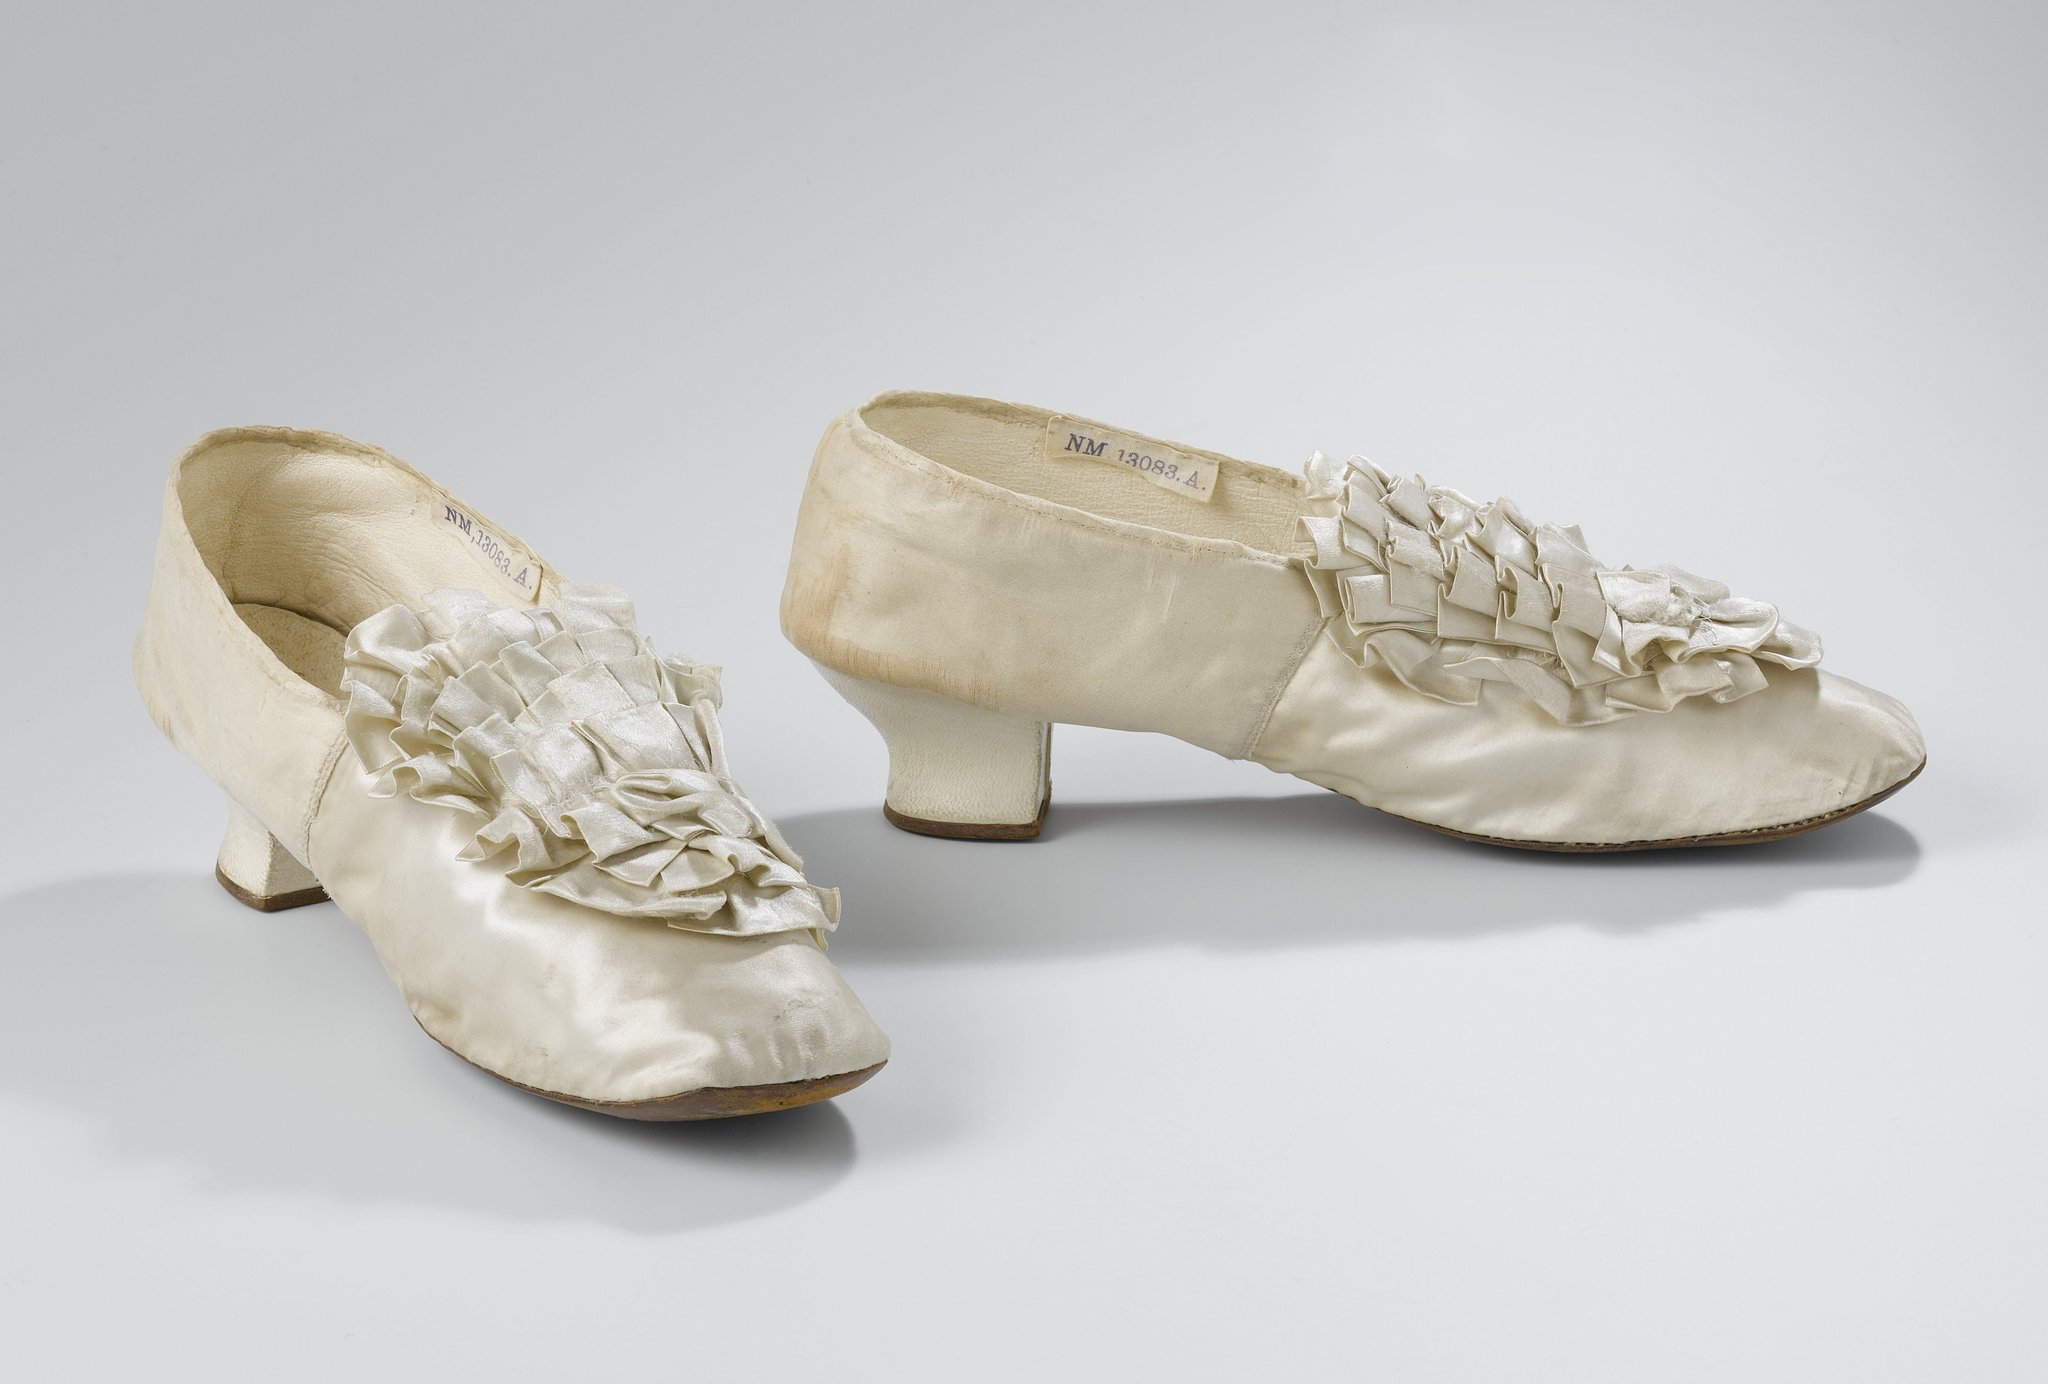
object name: womenswear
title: Damesschoen van ivoorwit satijn met rozet op de voorschoen en vierkante neus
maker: Anonymous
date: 1850-1860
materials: cotton, leather, rubber, silk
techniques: tanning, weave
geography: netherlands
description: Damesschoen van ivoorwit satijn. Model: Vierkante neus, één voorblad en één achterblad. De voorkant van de hak loopt recht naar beneden. De zijkant en achterkant van de hak zijn getailleerd en bekleed met ivoorwit satijn met donkerbruine rand leer van het achterlapje. Leren achterlapje met drie spijkers aan de hak vastgeslagen en leren zool. Achterblad gevoerd met ivoorwit leer, voorblad gevoerd met ivoorwit geribbeld katoen. De binnenzool is van ivoorwit leer. Versiering: Ivoorwit satijnen rozet midden op het voorblad. Onder het rozet zit een bruine elastieksluiting. Geen links/rechts verschil. Onder de hak drie spijkers ter verkoming van afslijten van de hak.